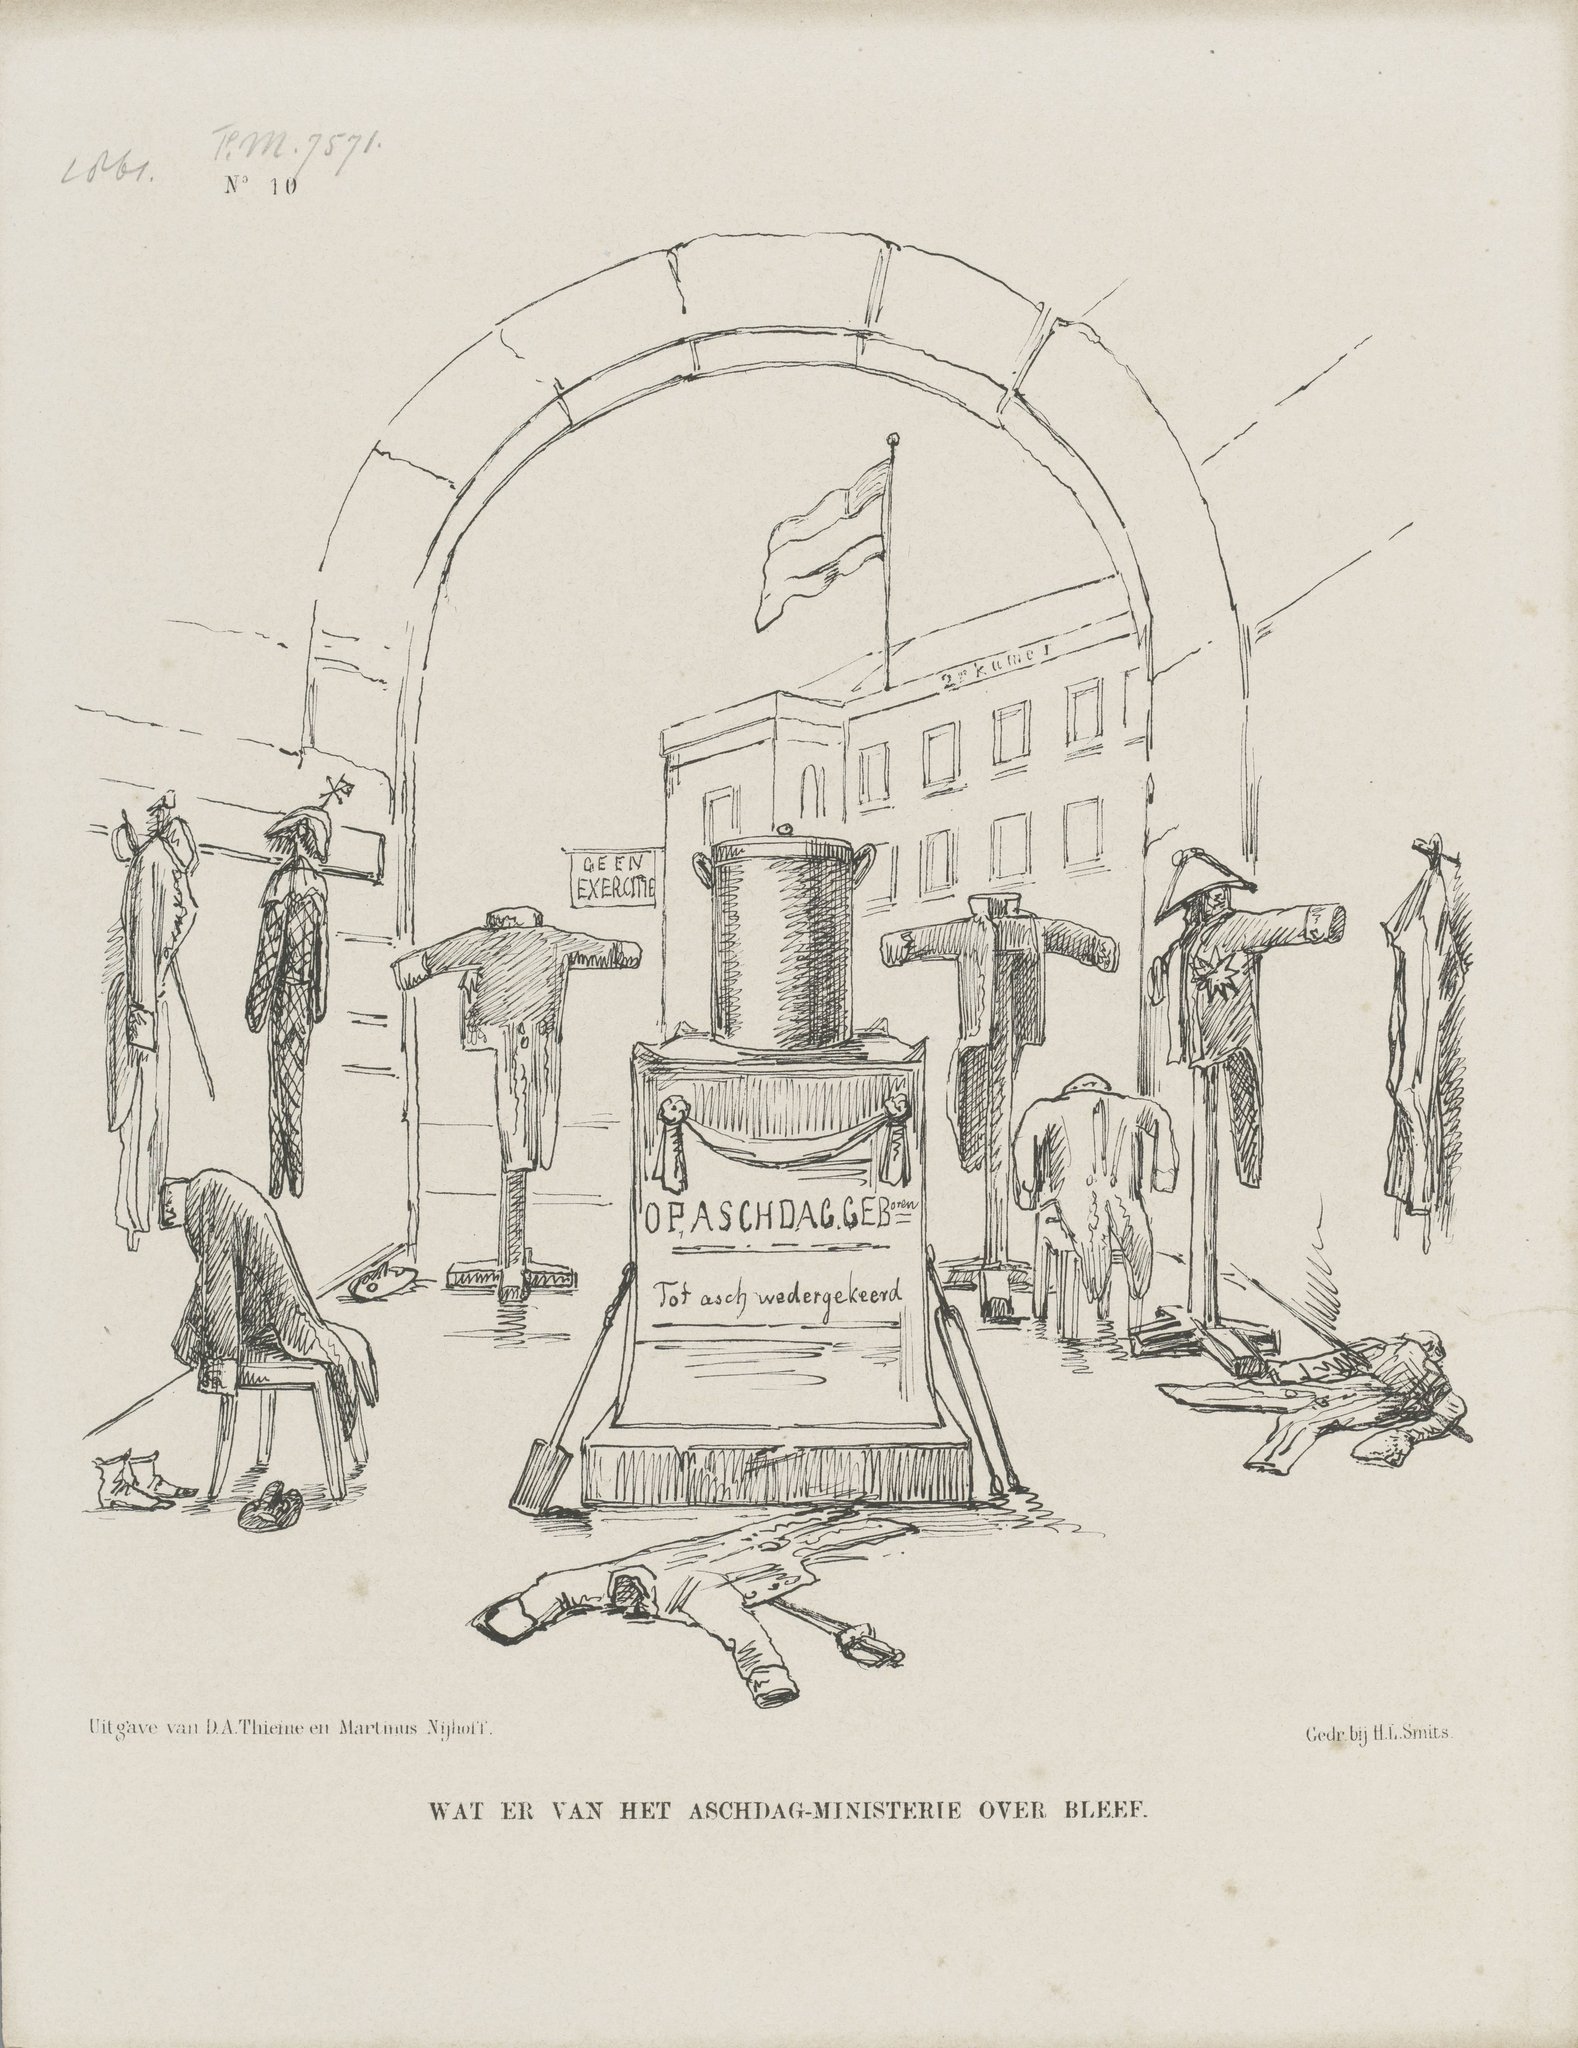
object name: print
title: Spotprent op het aftreden van minister F.A. van Hall, 1861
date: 1861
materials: paper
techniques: lithograph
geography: netherlands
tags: the hague, floris adriaan van hall, professional clothes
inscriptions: collector's mark: Lugt 2228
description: Spotprent op het aftreden van minister F.A. van Hall. Een doofpot staande op eeen voetstuk, daaromheen de galakleding van de minister. Plaat verschenen bij het weekblad De Nederlandsche Spectator, nr. 10, 9 maart 1861.